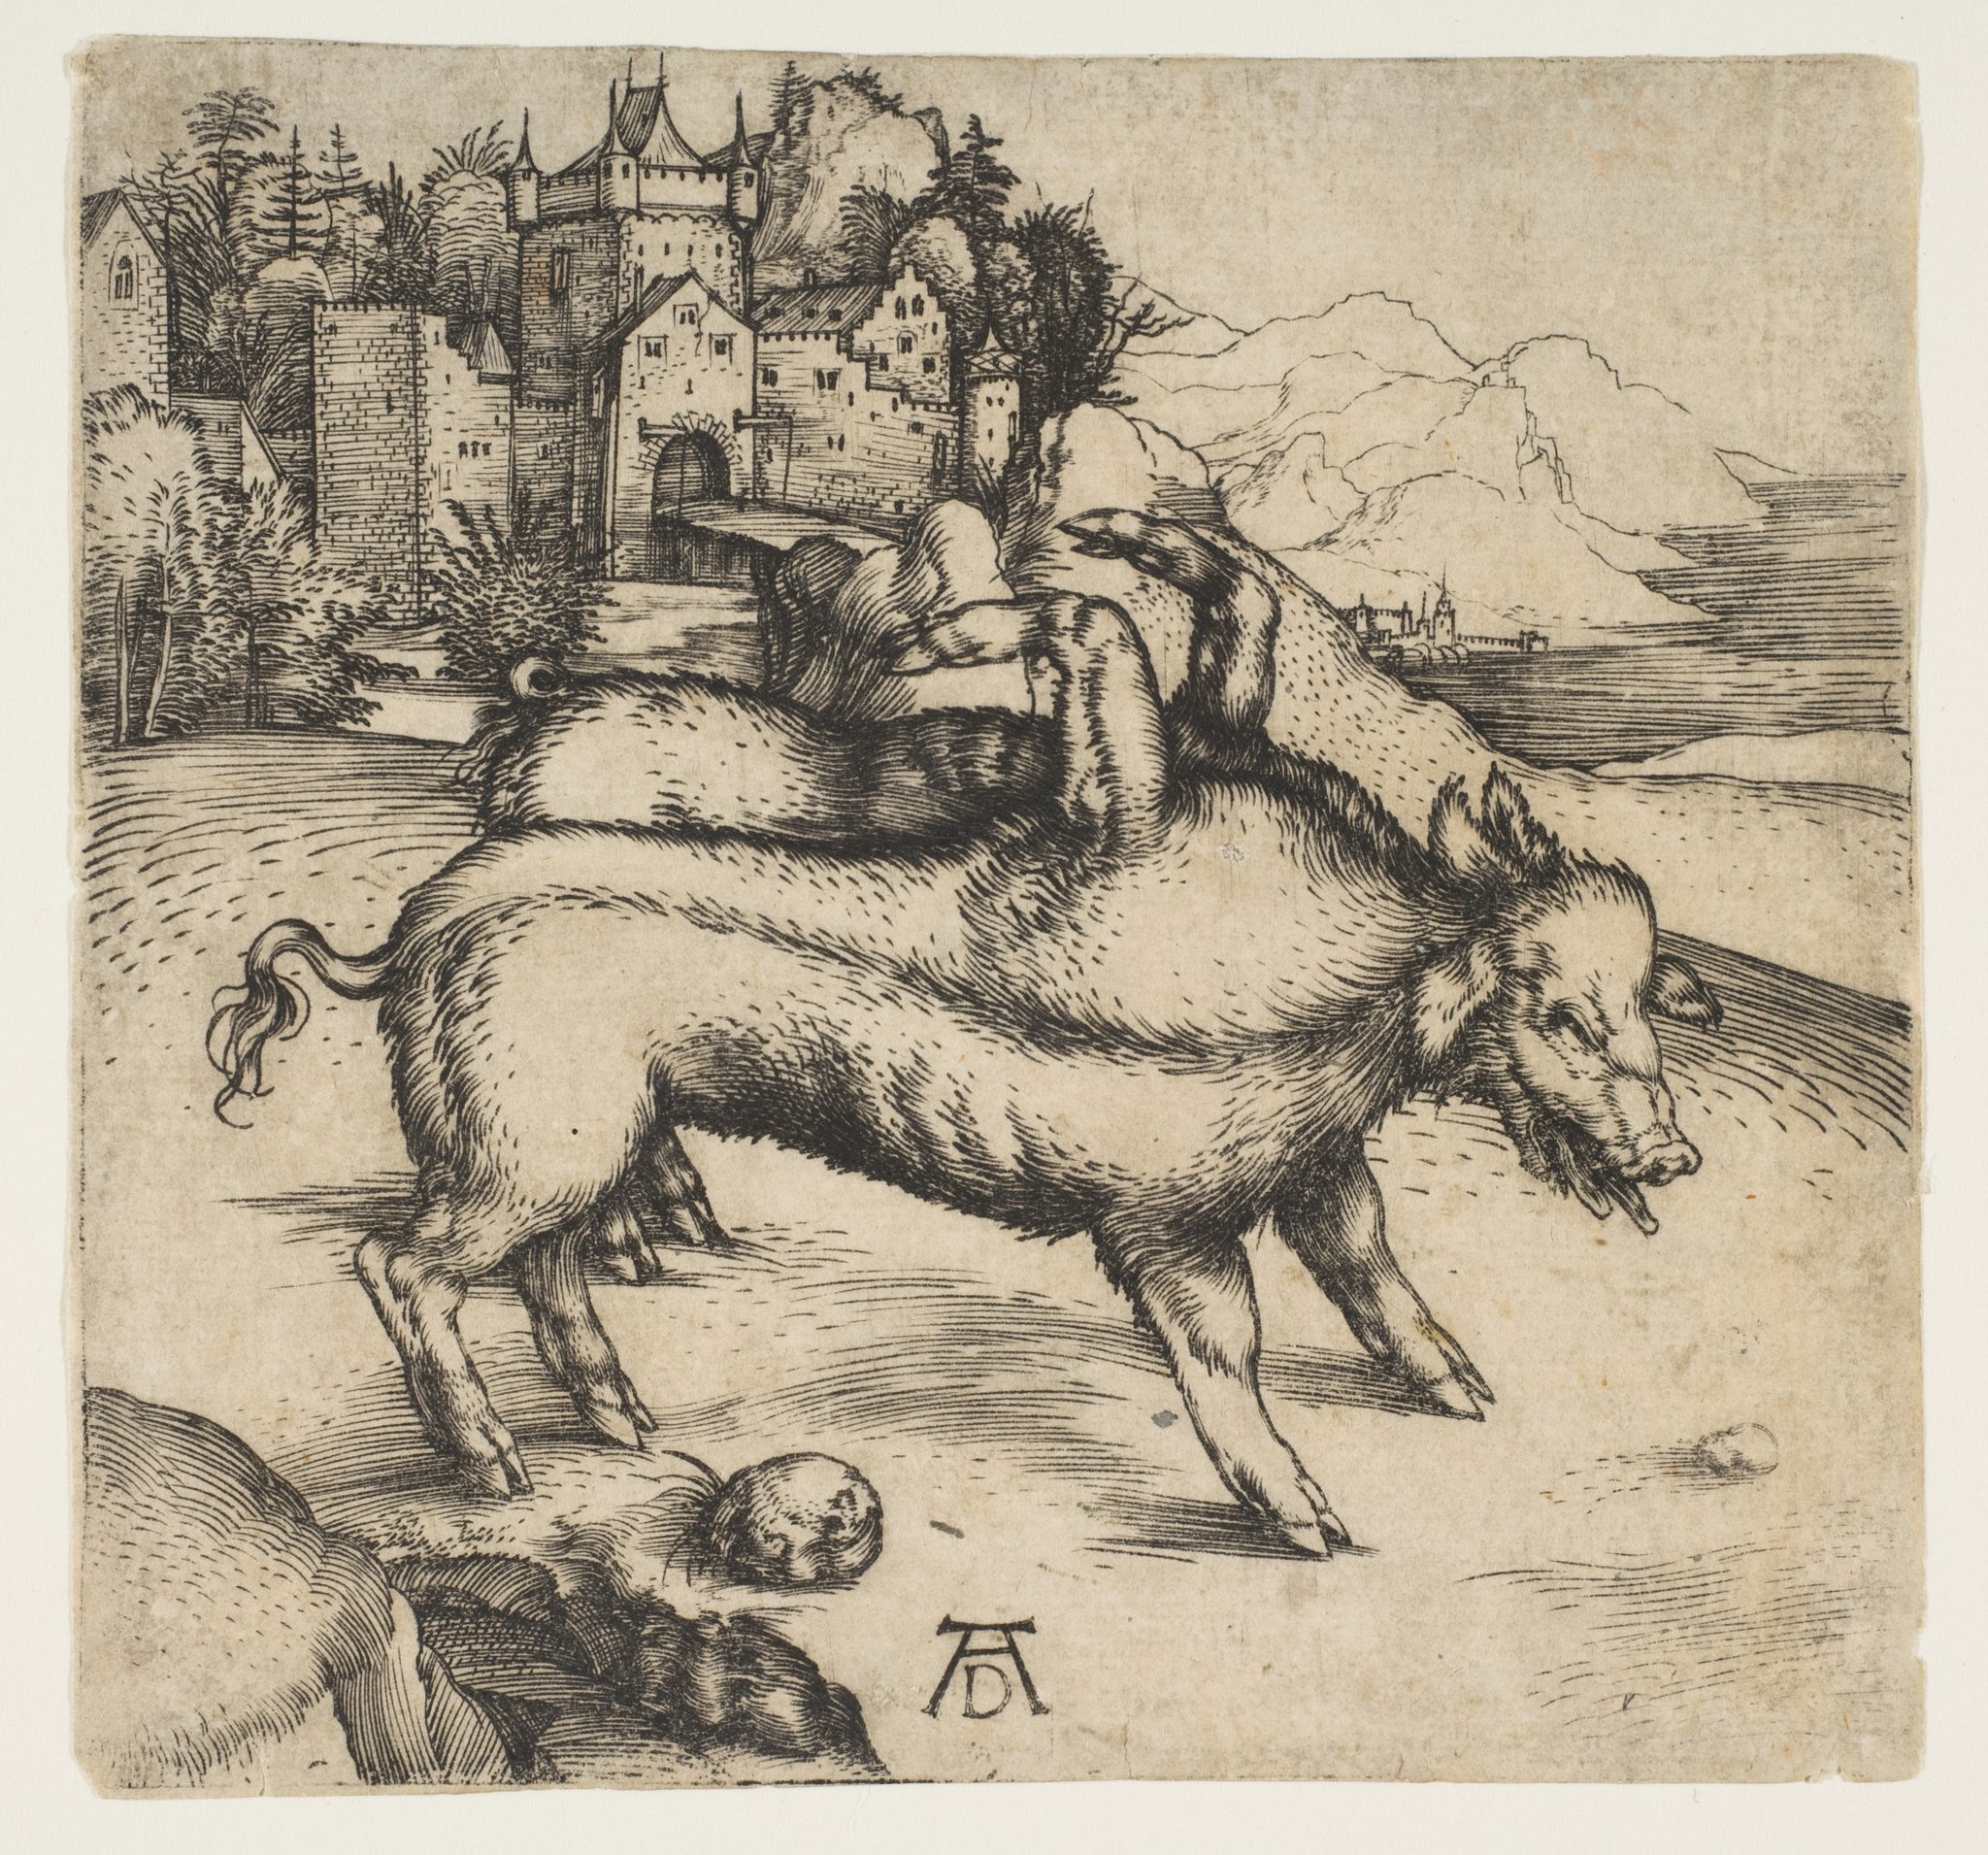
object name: print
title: The Monstrous Pig of Landser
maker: albrecht dürer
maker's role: artist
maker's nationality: german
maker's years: 1471-1528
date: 1496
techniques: engraving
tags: buildings,pigs